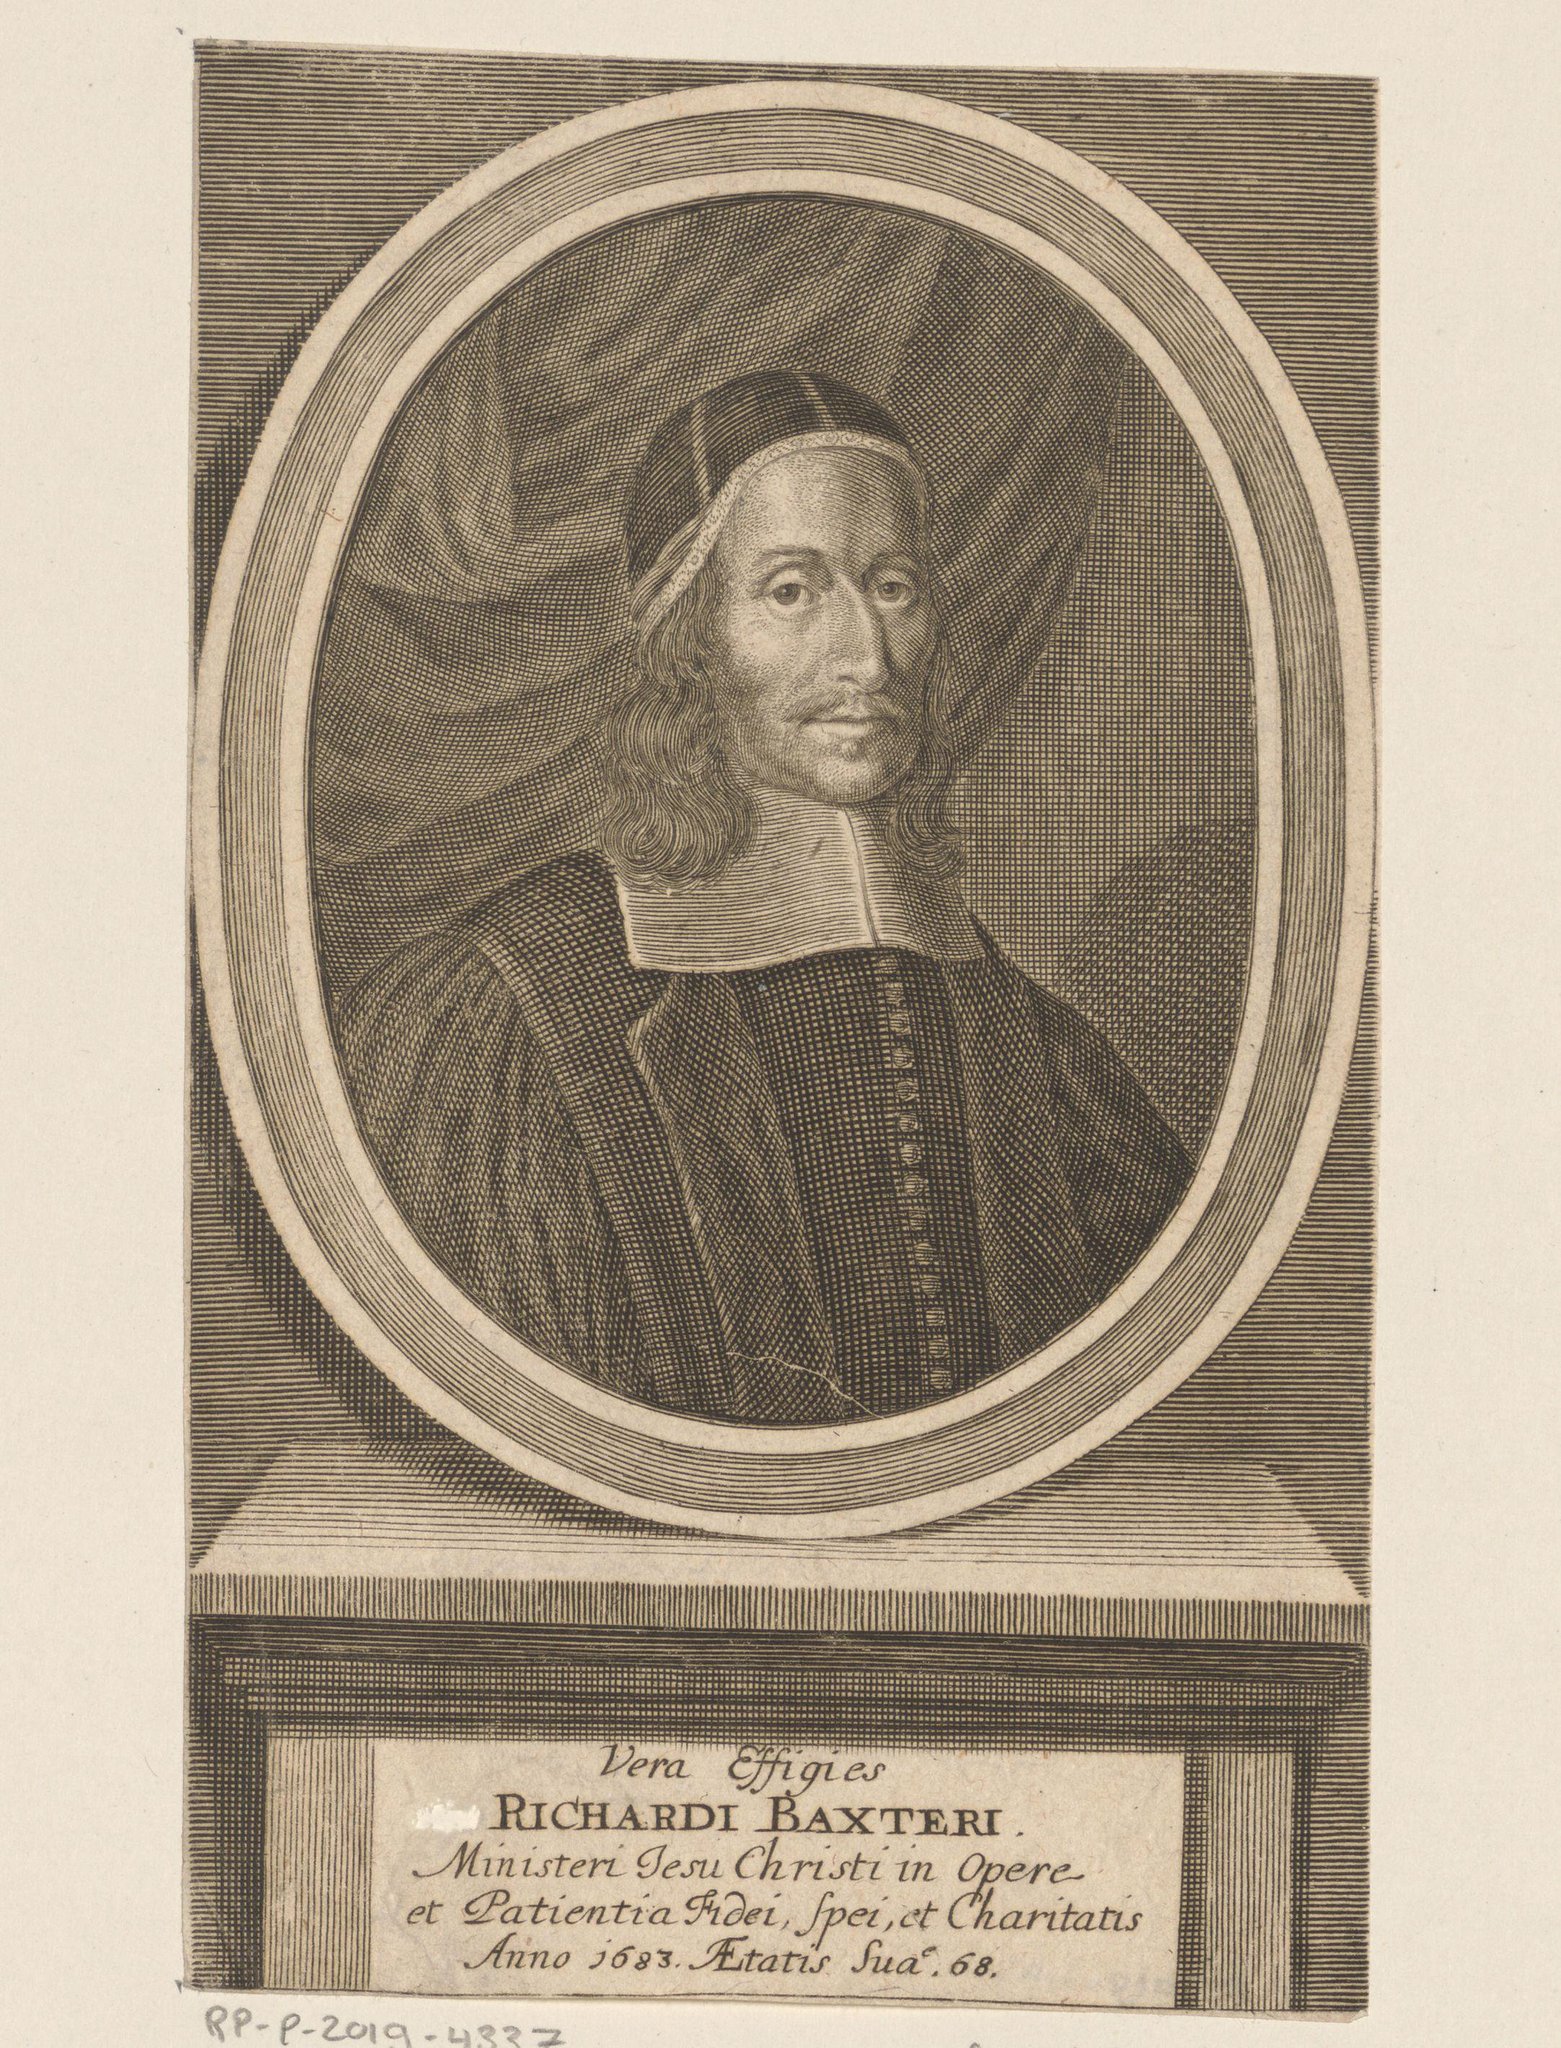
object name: book illustration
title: Portret van Richard Baxter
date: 1685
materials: paper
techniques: engraving, etching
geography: hanau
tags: london, historical persons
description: Prent uit: Baxter, Richard. Ein Heiliger oder Ein Vieh. Das ist: Eine Verhandlung des elendigen Standes derer ohne Gott und Heiligkeit lebenden Menschen (...). Hanau: Karl Scheffer, 1685.